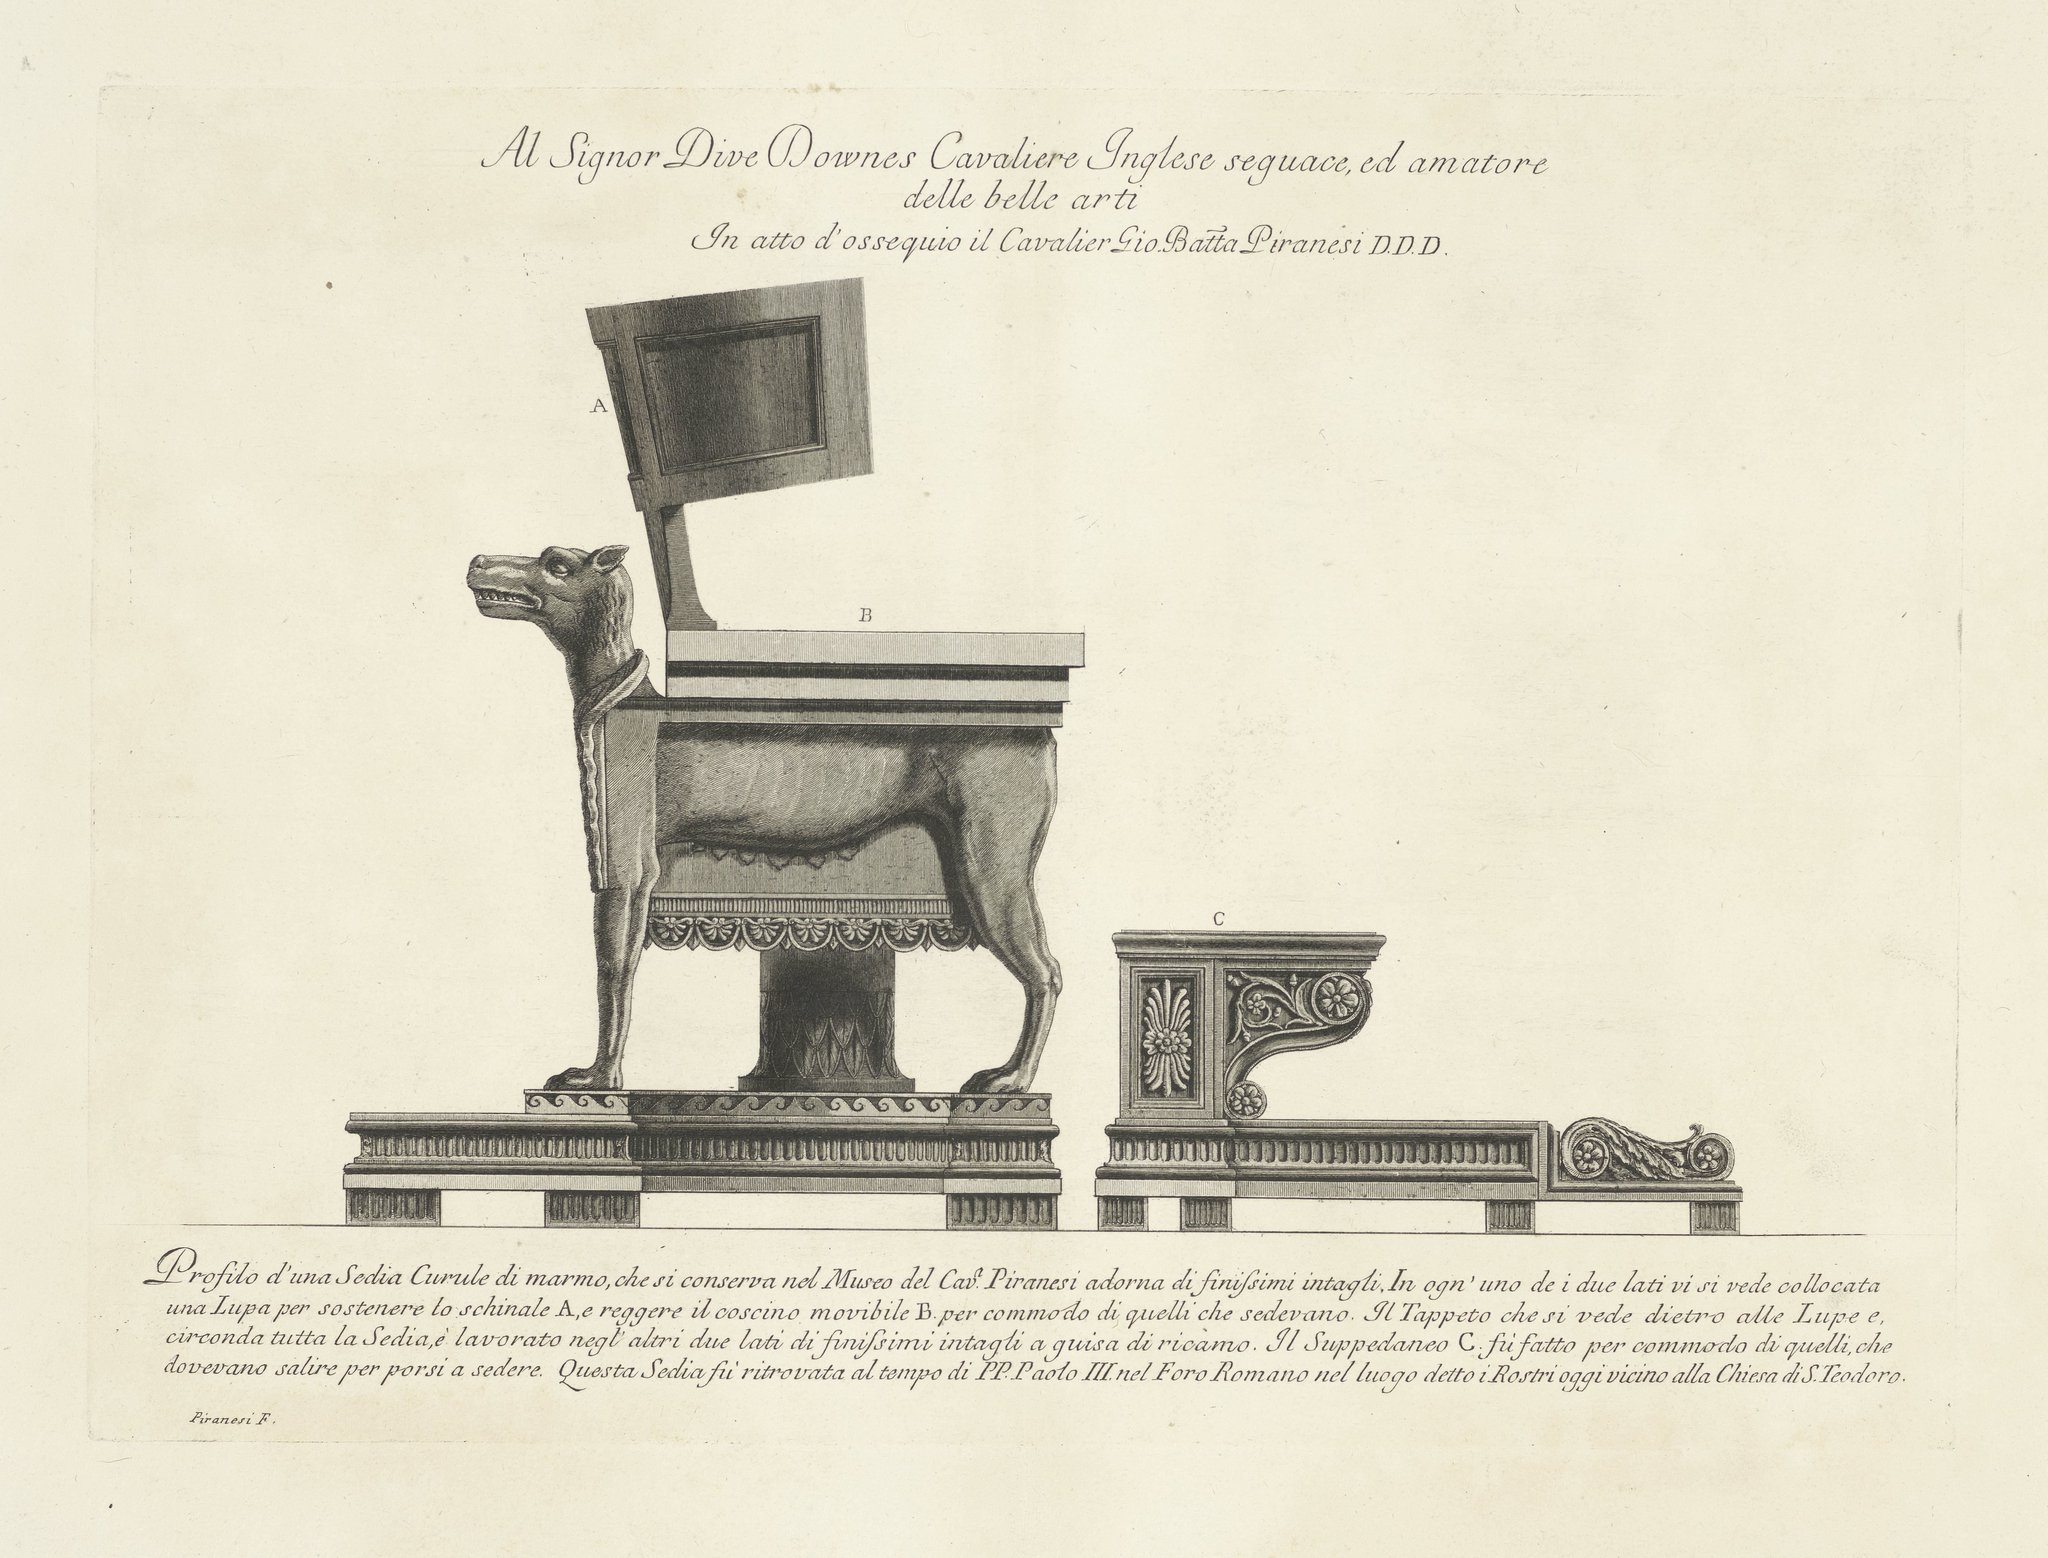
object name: print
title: Ambtszetel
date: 1778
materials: paper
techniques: etching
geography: rome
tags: chair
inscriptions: collector's mark: Lugt 2228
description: De 'Vasi'-reeks telt 110 prenten, verspreid over twee volumes met elk een eigen titelprent. Piranesi werd voor deze reeks geholpen door verschillende assistenten uit zijn werkplaats, waaronder zijn zoon Francesco die ook nog eens 8 platen toevoegde aan de reeks in 1779-1780.